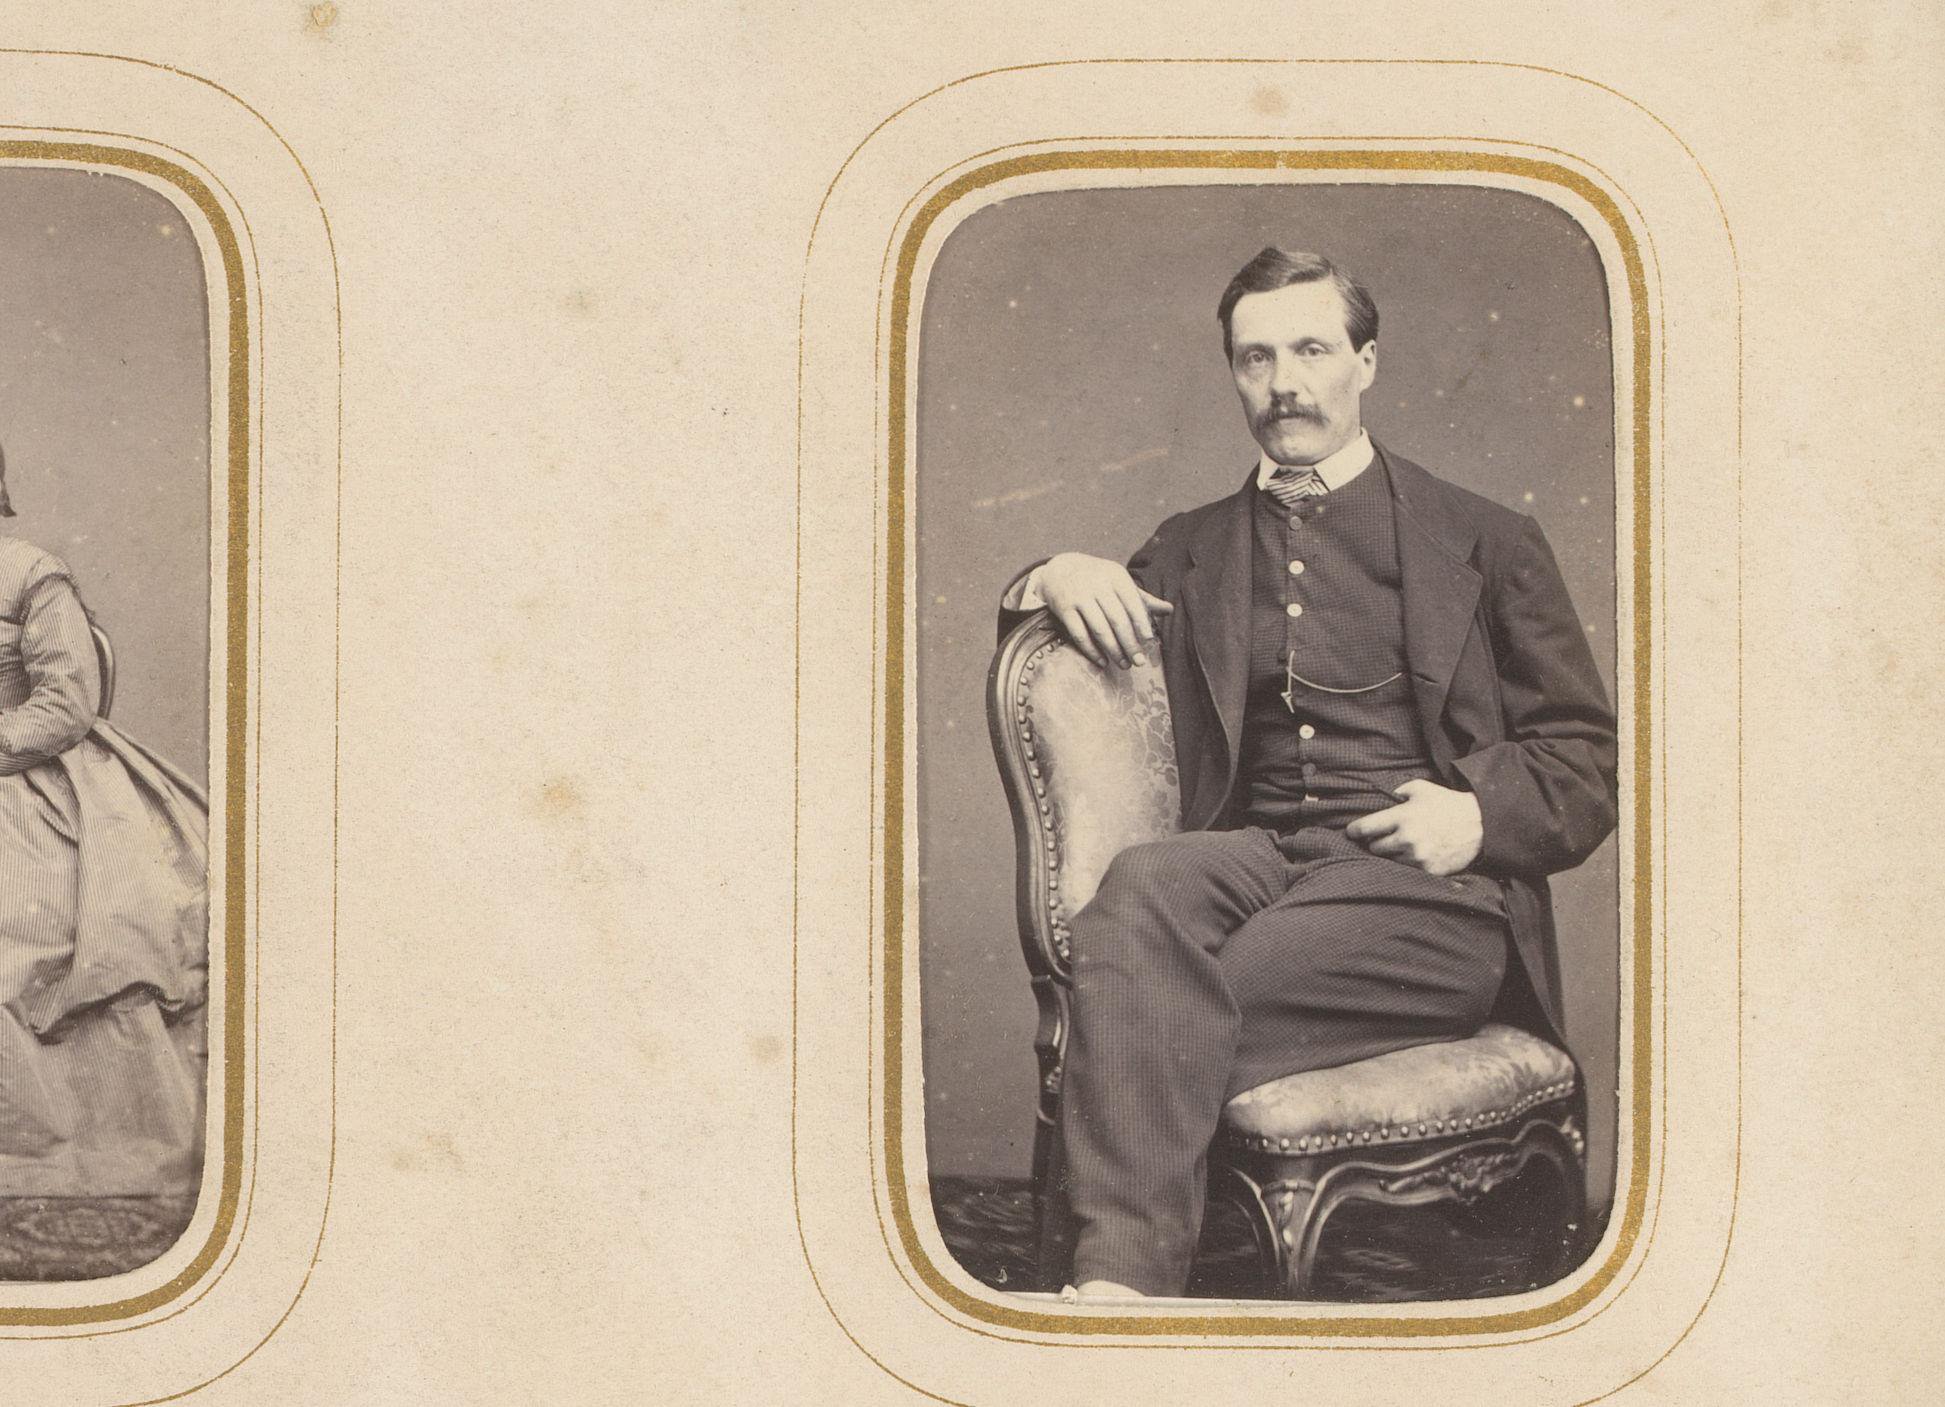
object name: album leaf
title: Portret van een zittende man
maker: victoire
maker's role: fotograaf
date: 1860-1890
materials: cardboard, photographic support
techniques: albumen print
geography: lyon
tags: historical persons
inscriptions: inscription: ‘Victoire/ Rue St. Pierre, 22, au 1er Etage/ Lyon’